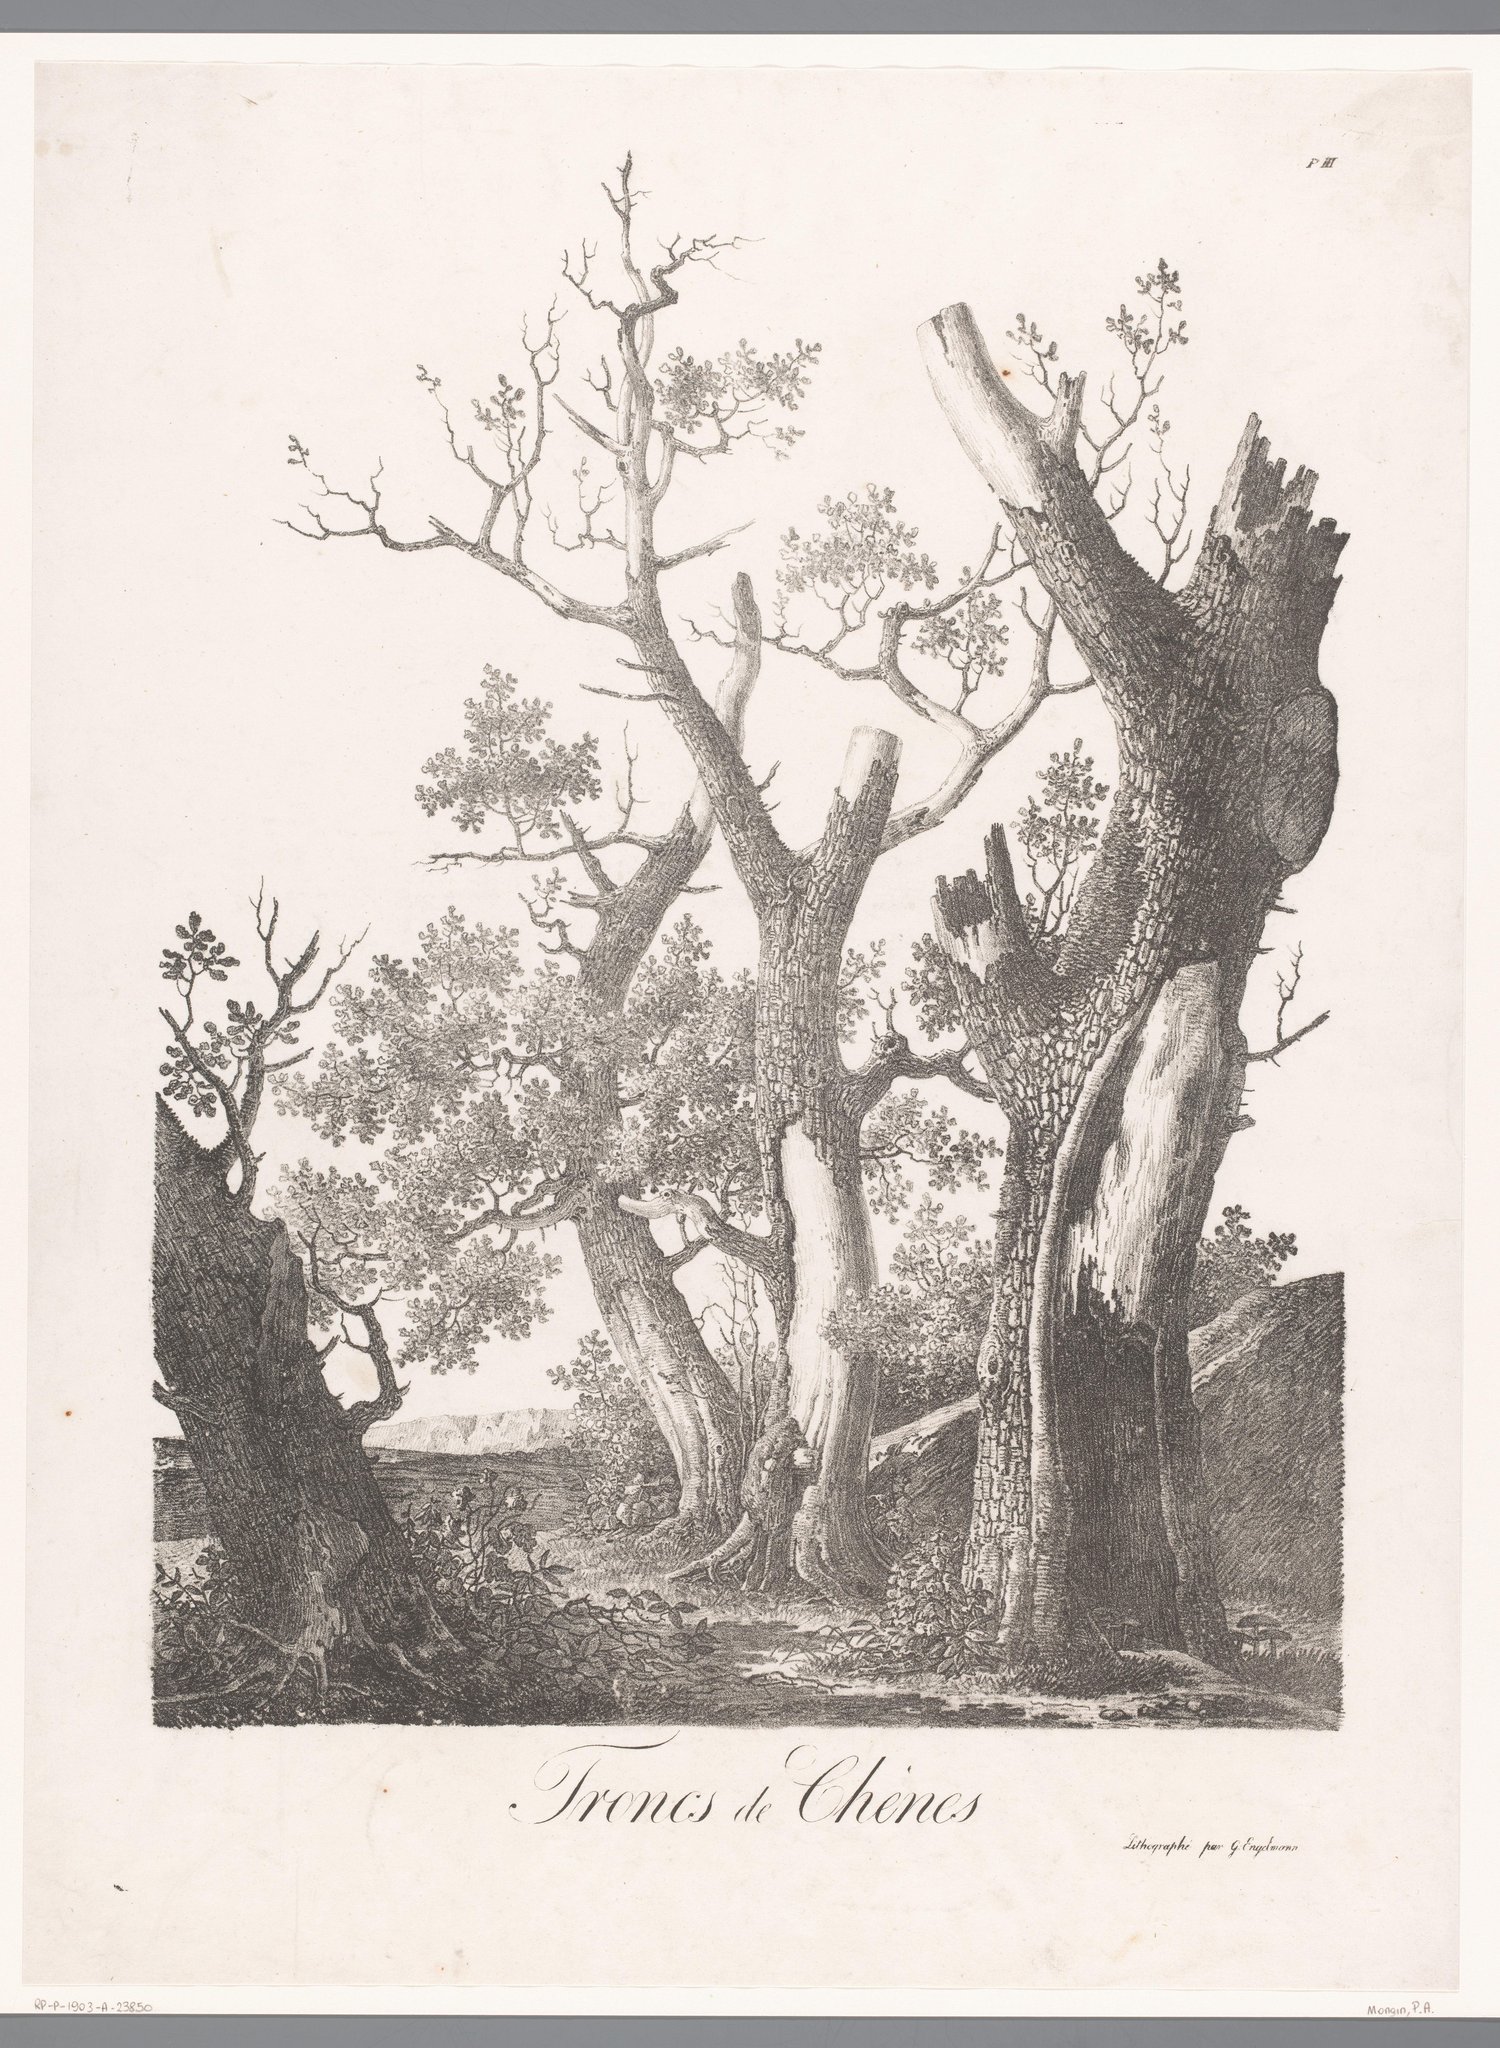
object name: print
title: Troncs de chênes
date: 1816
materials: paper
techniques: lithograph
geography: paris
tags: trees: oak (+ stem, trunk)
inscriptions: collector's mark: Lugt 2228